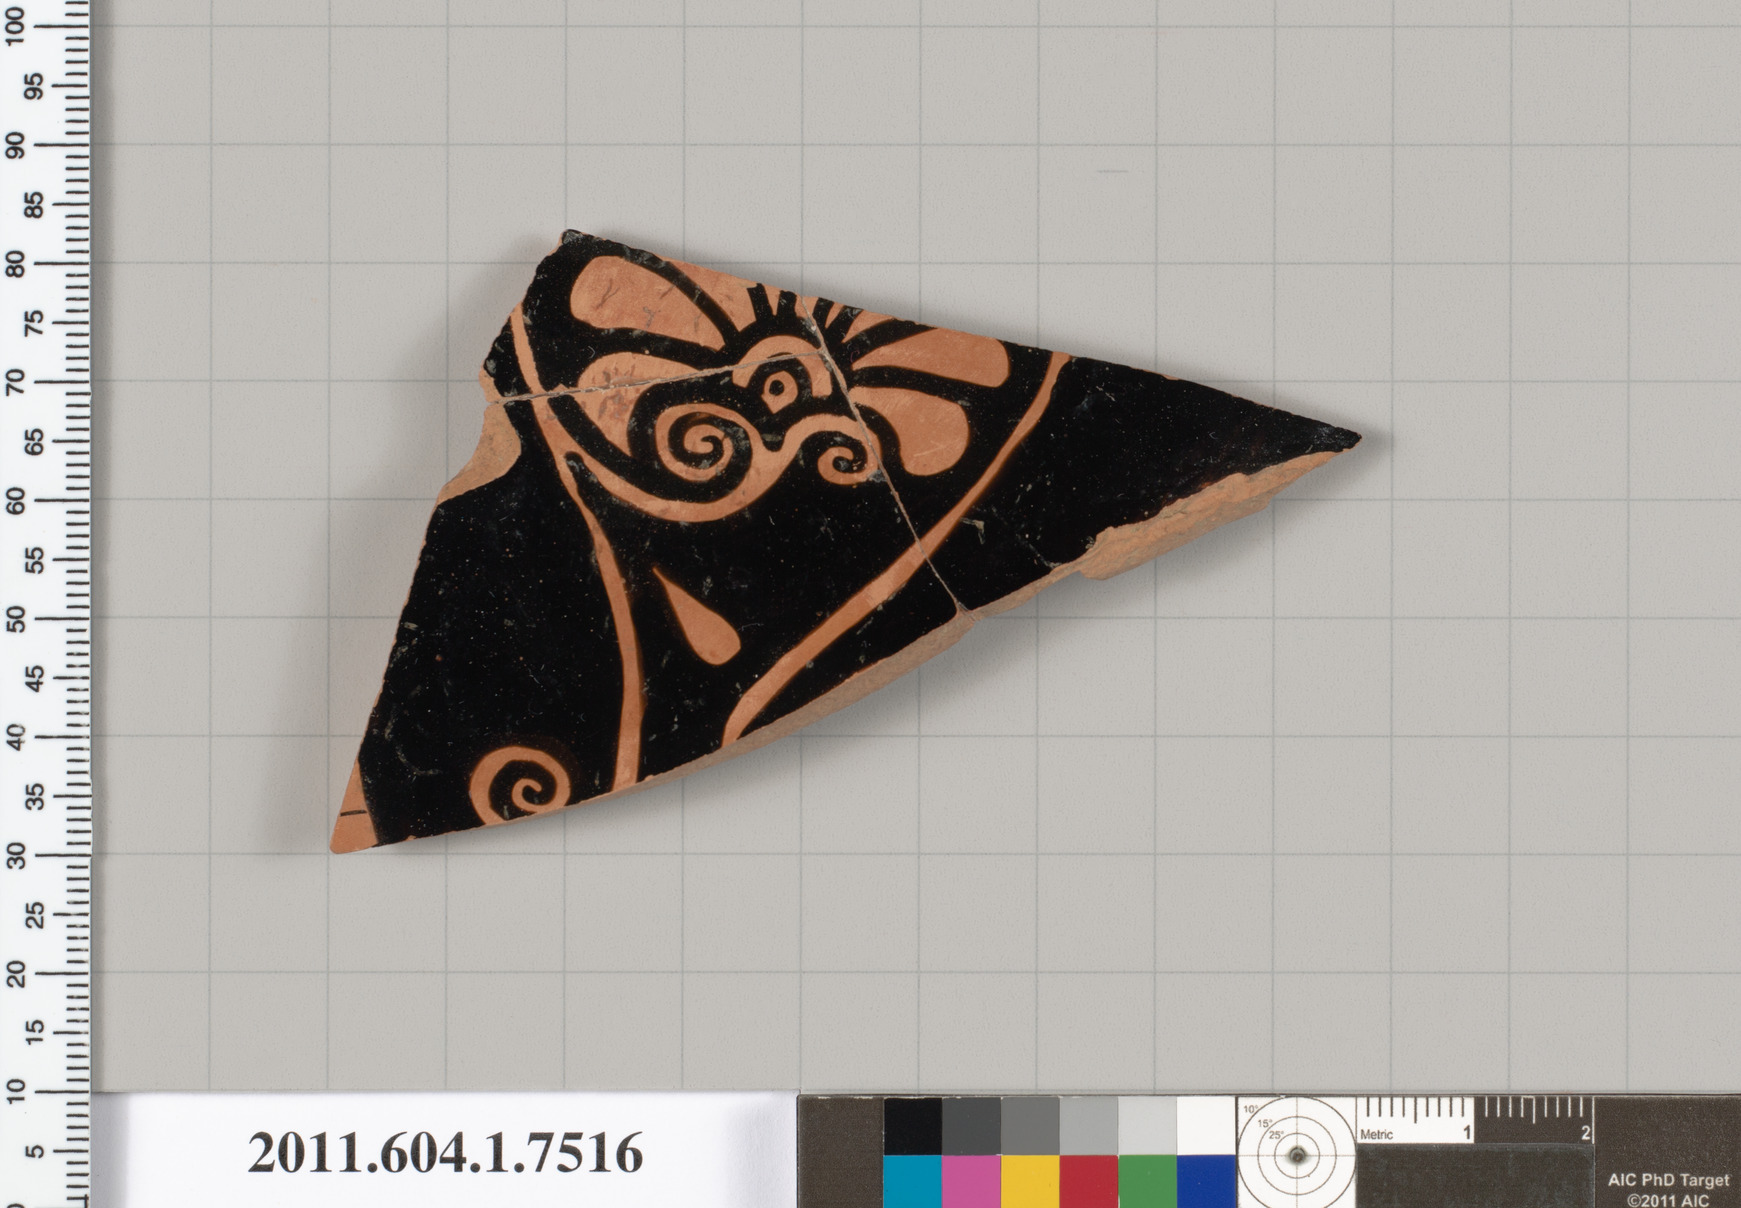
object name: kylix fragment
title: Terracotta fragment of a kylix (drinking cup)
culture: greek, attic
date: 460-450 BCE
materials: terracotta